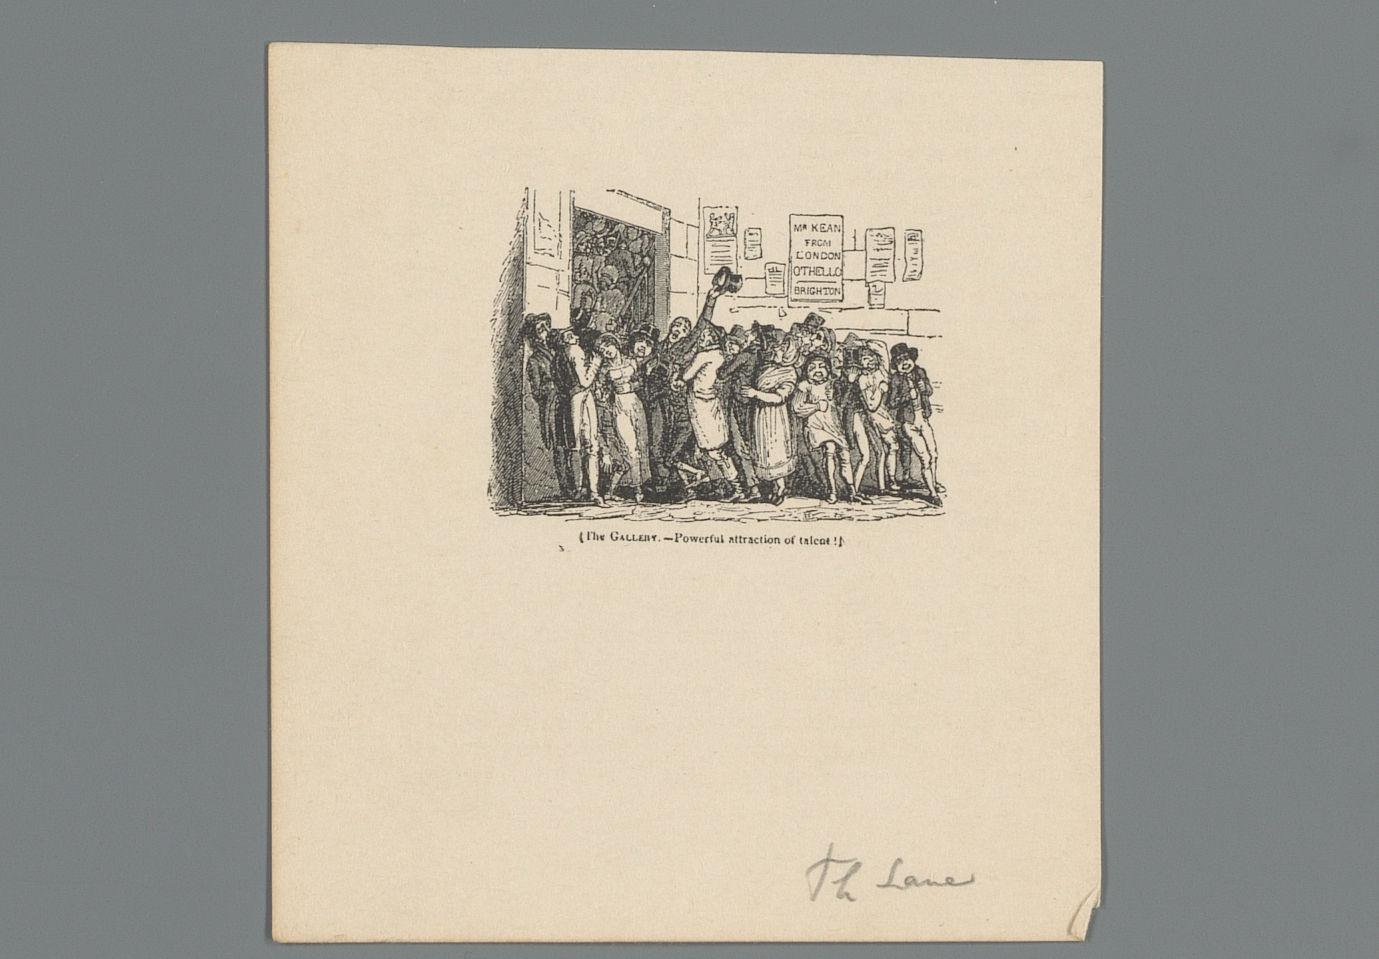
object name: cartoon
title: The Gallery - Powerful attraction of talent!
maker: theodore lane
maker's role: draughtsman, painter, print maker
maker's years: 1800-1828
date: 1823-1825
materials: paper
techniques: etching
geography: england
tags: theatre, theatrical performance, the audience ~ art performance, political caricatures and satires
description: Theaterpubliek buiten dringt om het theater binnen te komen. Onderdeel van een groep van zeven boekillustraties uit: The Life of an Actor (1825).